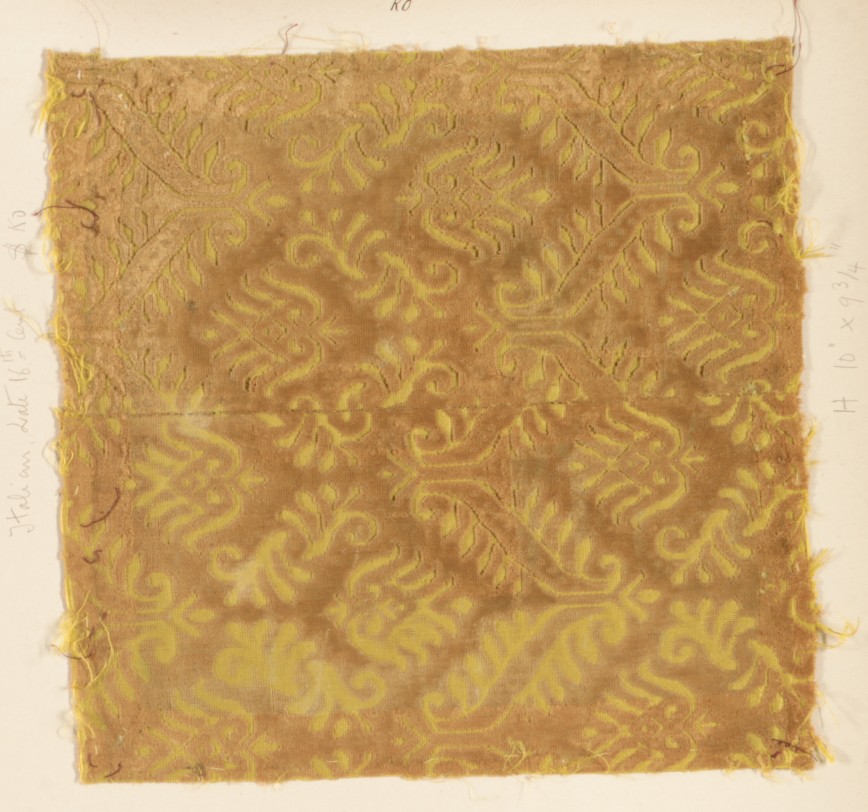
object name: fragment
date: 1567-1600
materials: silk